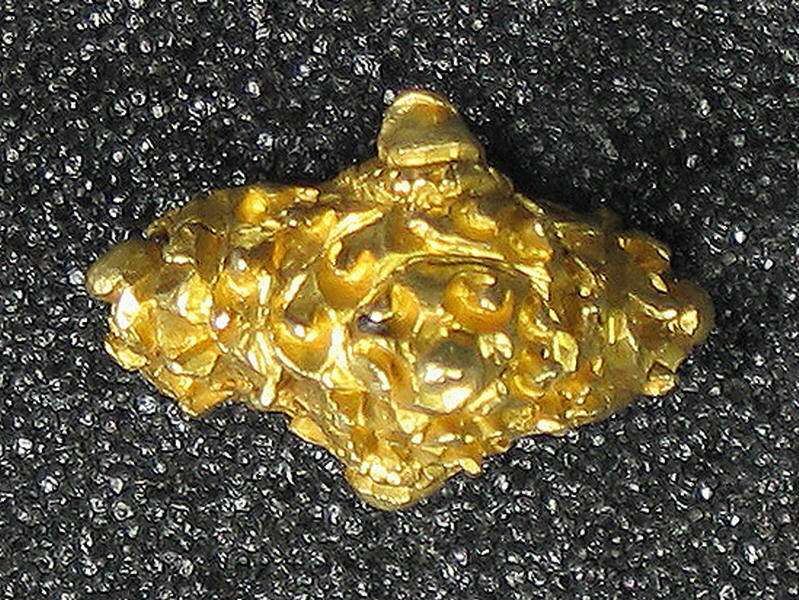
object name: earring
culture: indonesian, central java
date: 701-1200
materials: gold